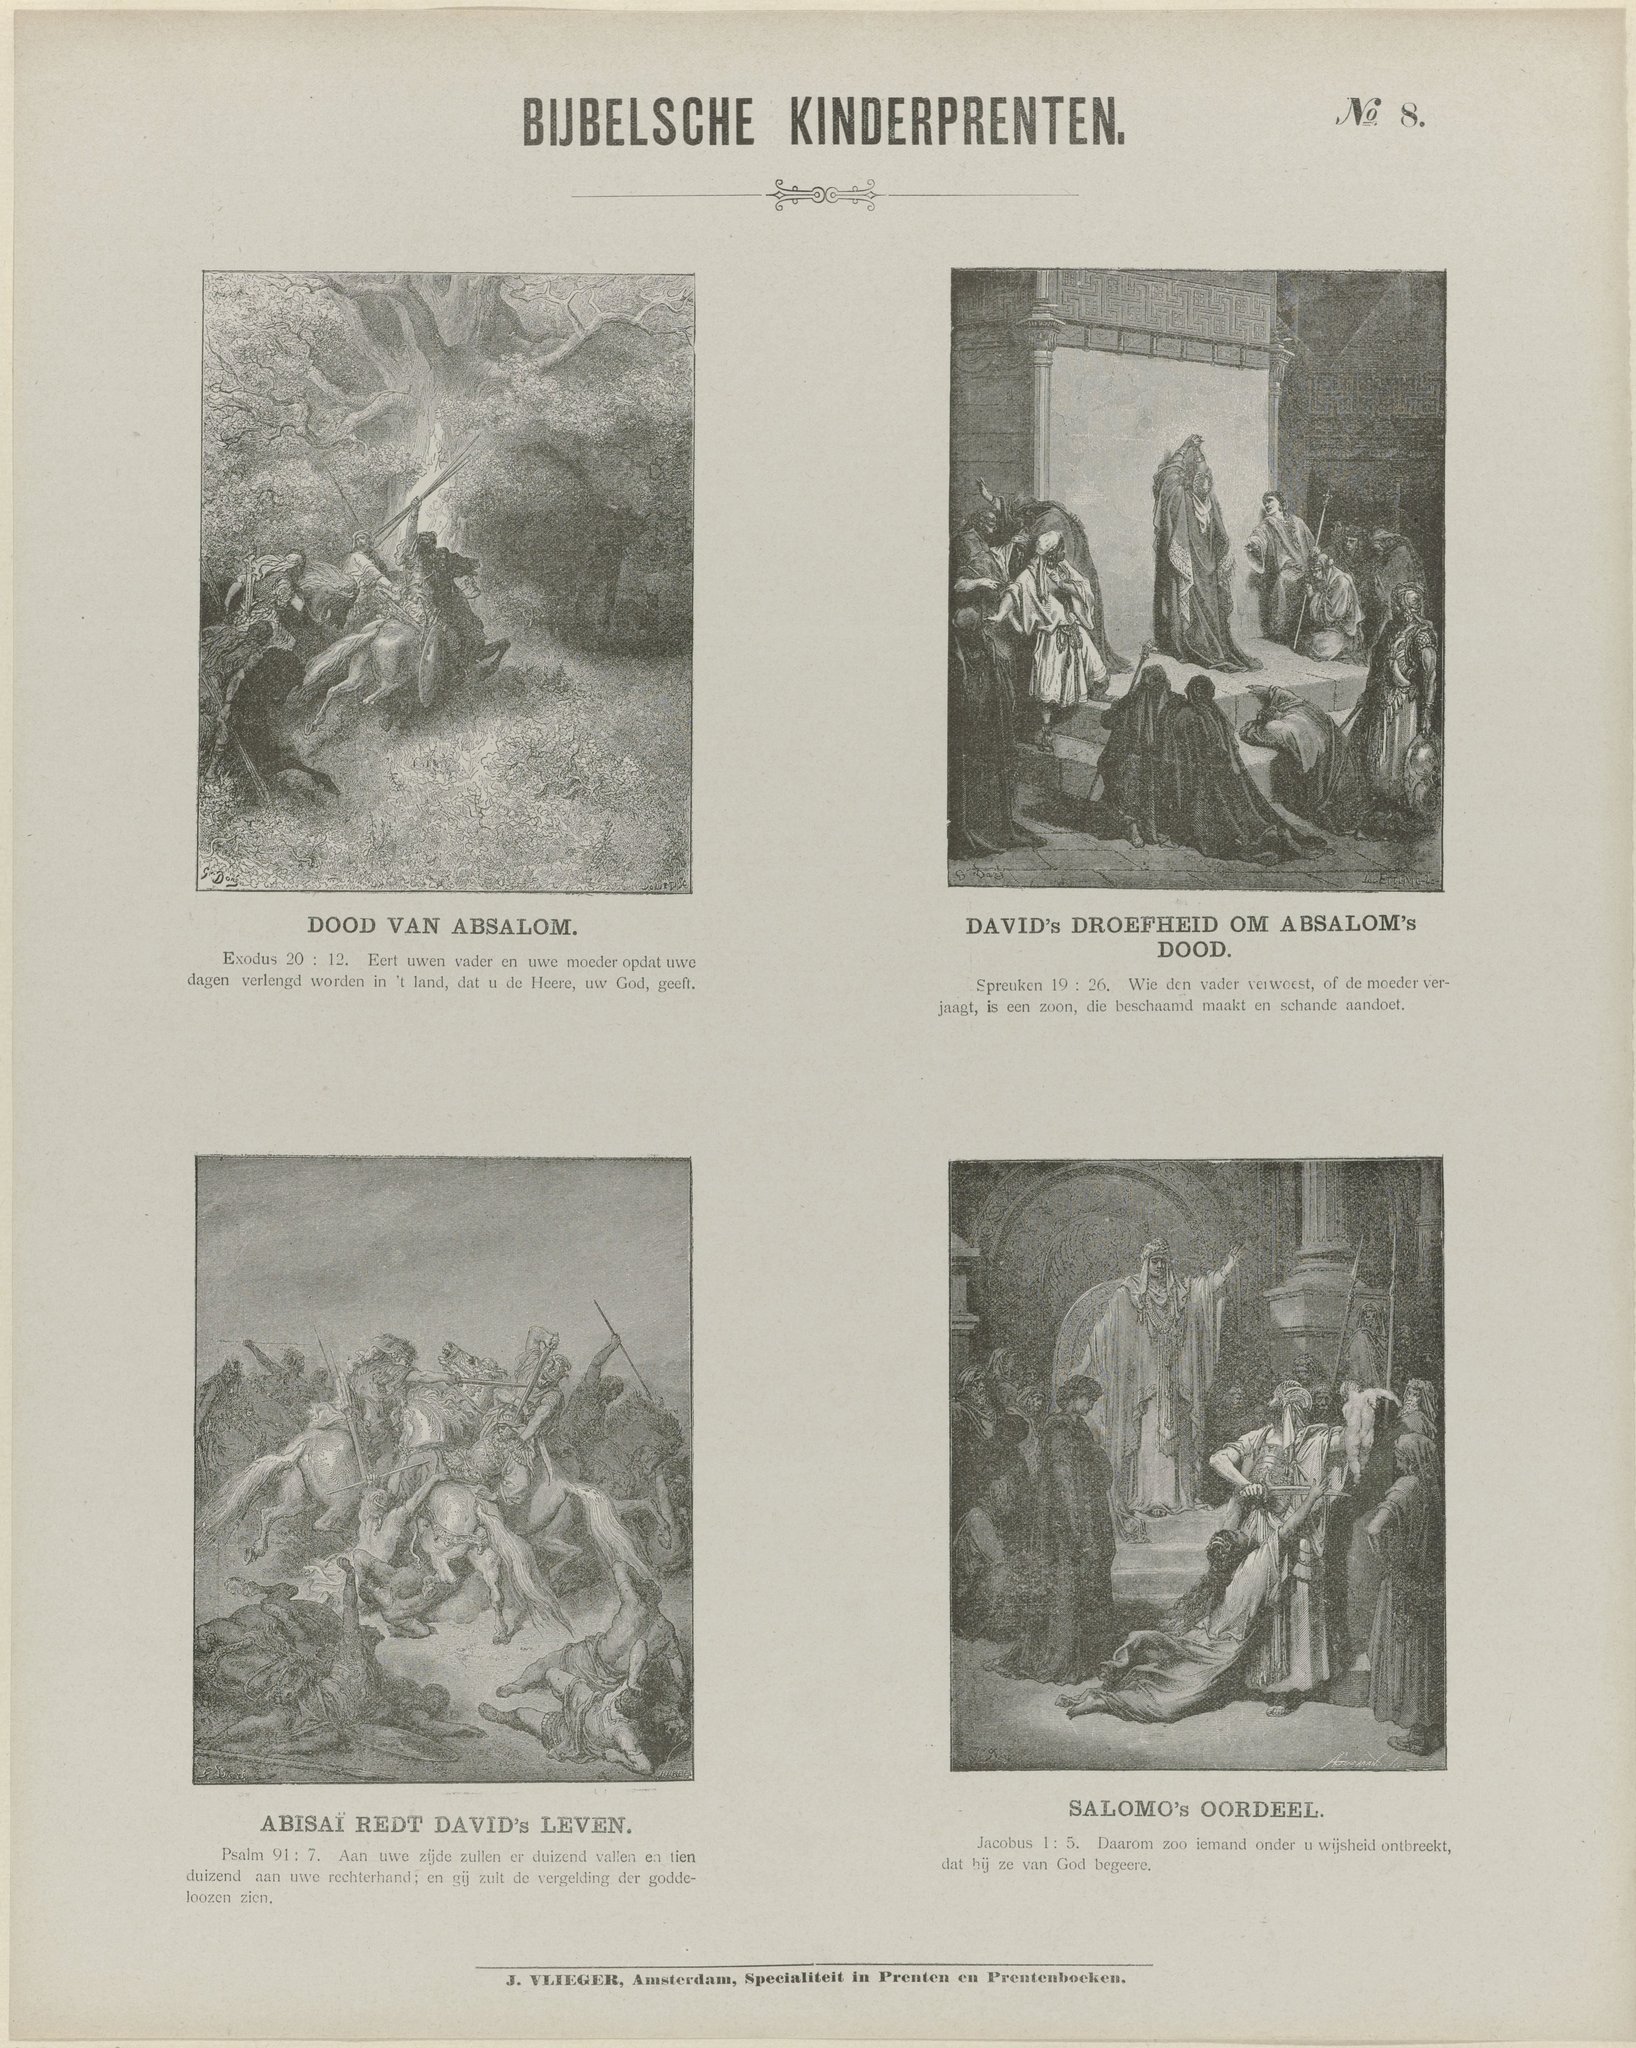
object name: popular print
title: Bijbelsche kinderprenten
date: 1869-1908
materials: paper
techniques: letterpress printing, photoaquatint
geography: amsterdam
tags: david mourning for absalom's death, the philistines attack david, the true mother objects to solomon's verdict, absalom, put to flight on a mule, remains hanging by his hair in an oak-tree, old testament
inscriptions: collector's mark: Lugt 2760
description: Blad met 4 voorstellingen van verhalen uit het Oude Testament. De dood van Absalom, David treurt om de dood van zijn zoon Absalom, Abisaï redt het leven van David en het oordeel van Salomo. Onder elke afbeelding een Bijbeltekst. Genummerd rechtsboven: No. 8.